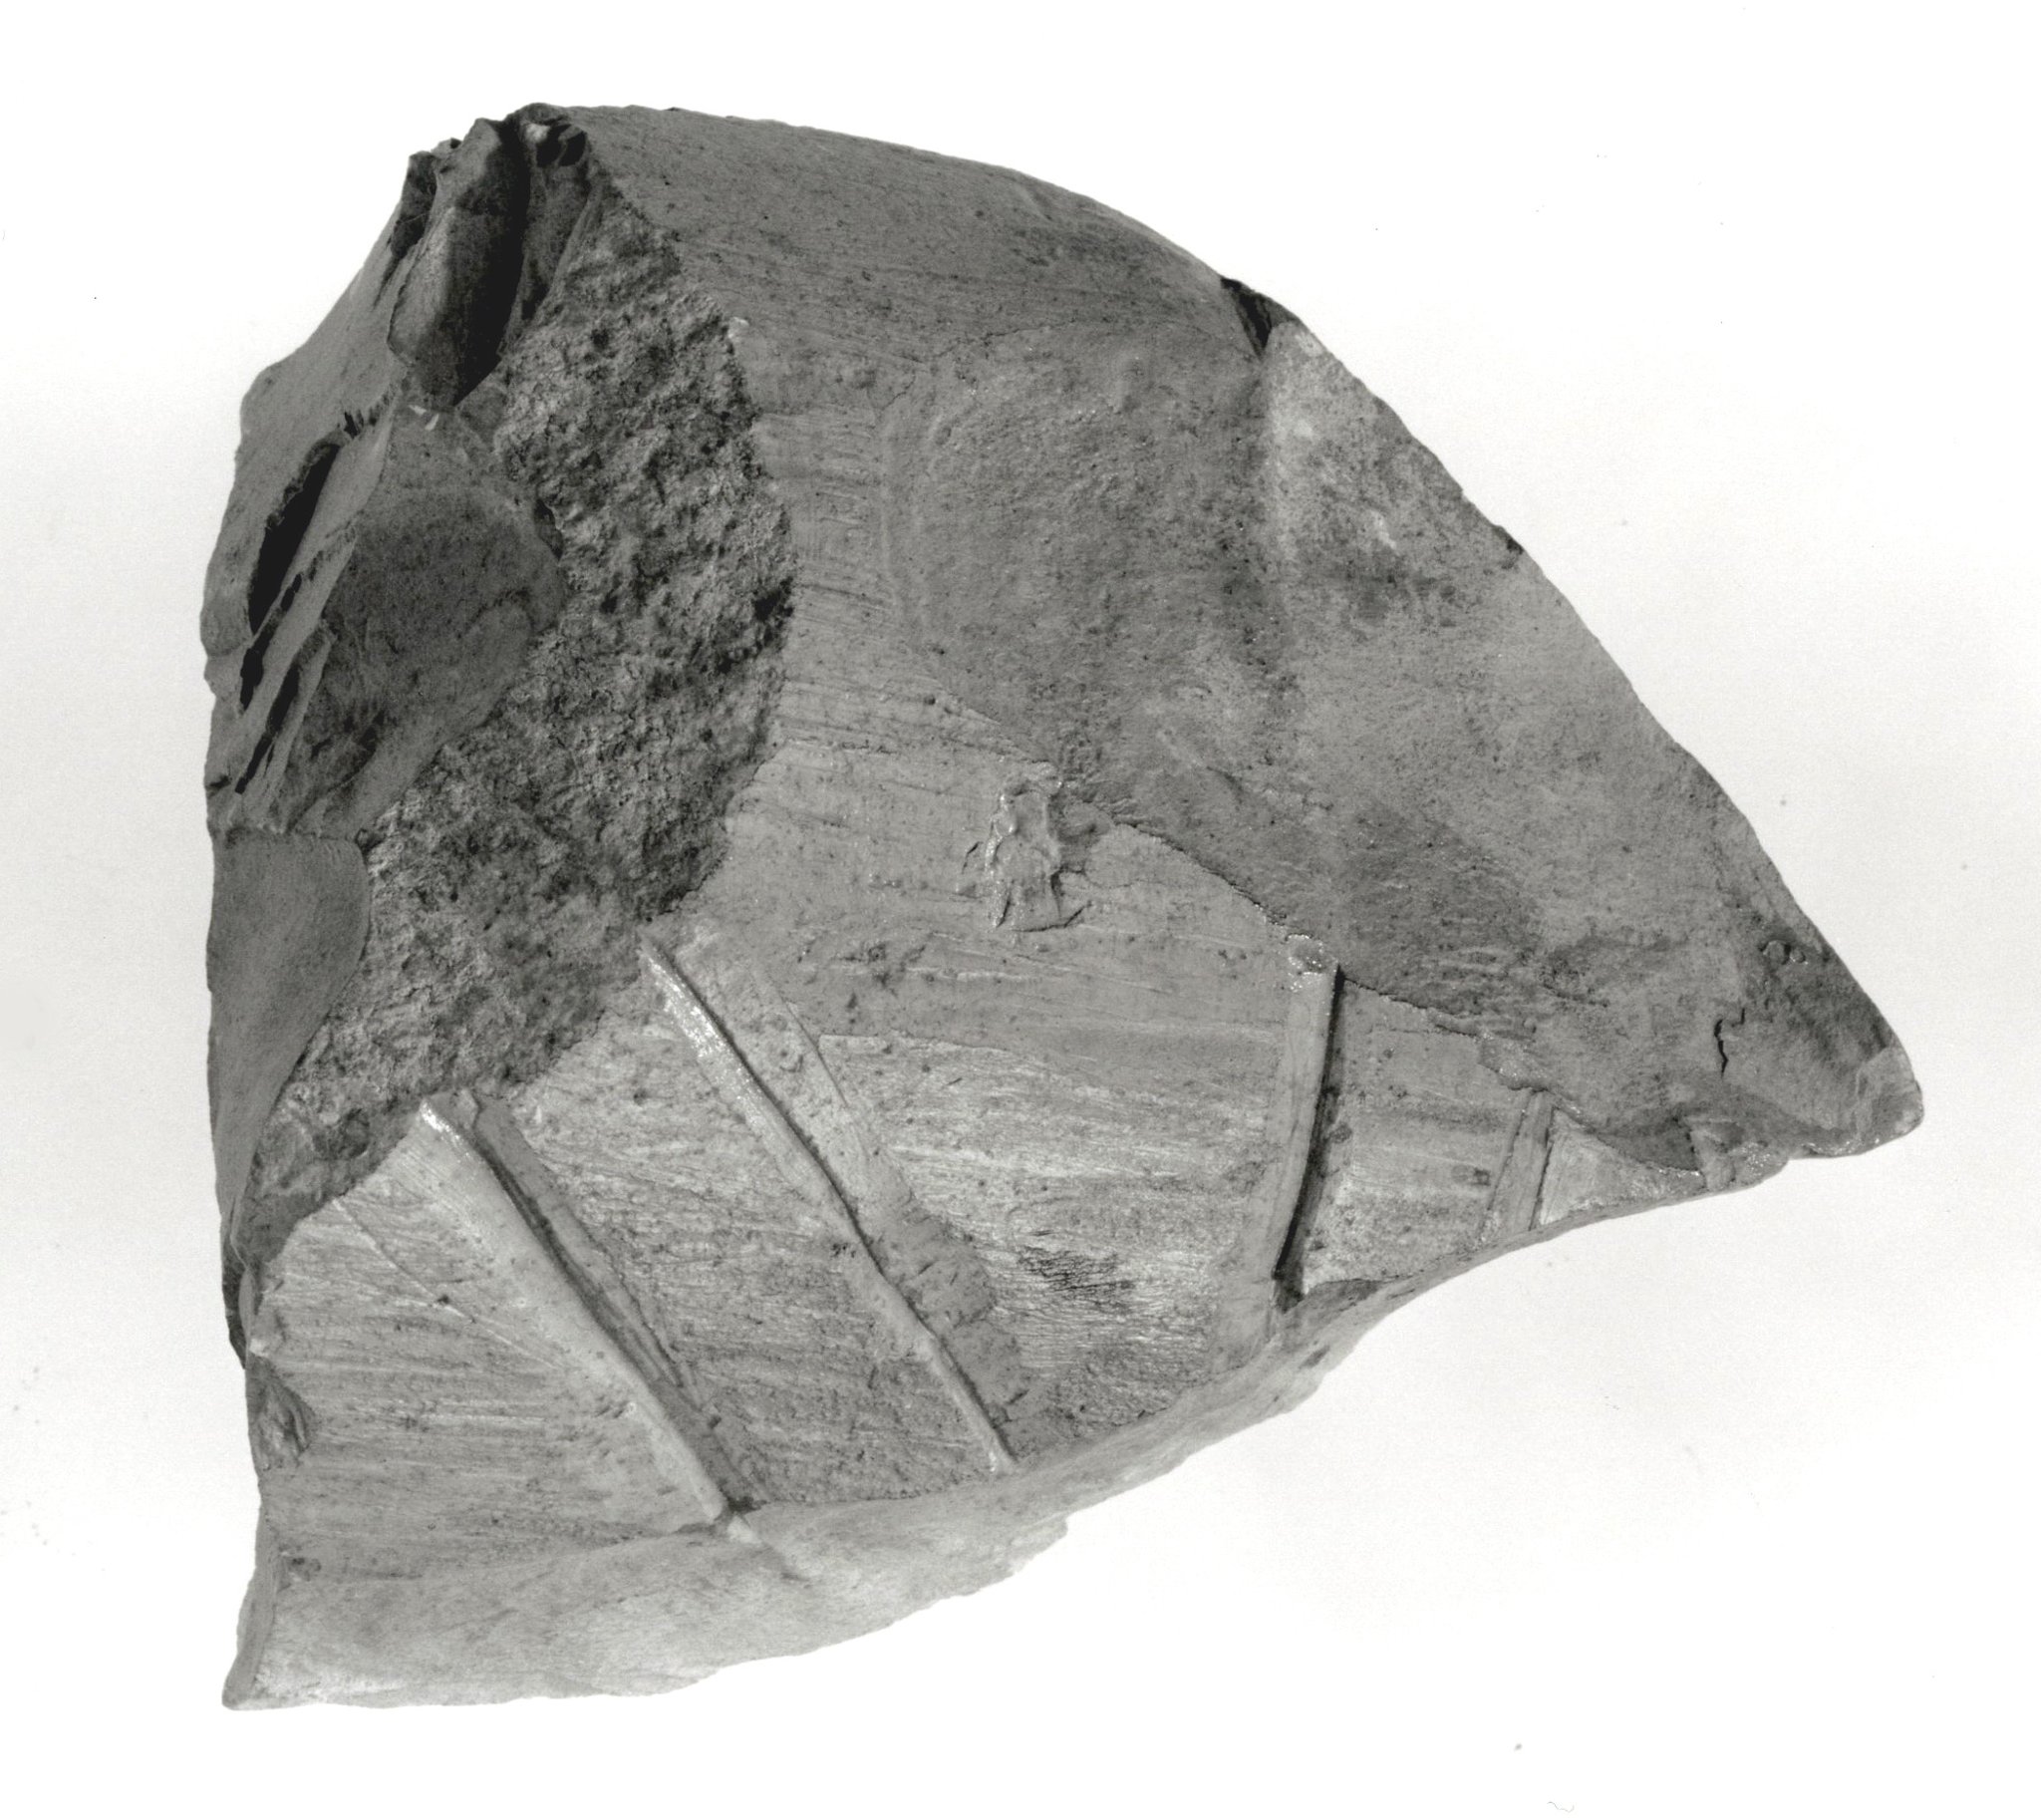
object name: relief, tomb of nespekashuty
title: Raised relief fragment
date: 664-610 BCE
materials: limestone, varnish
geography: egypt